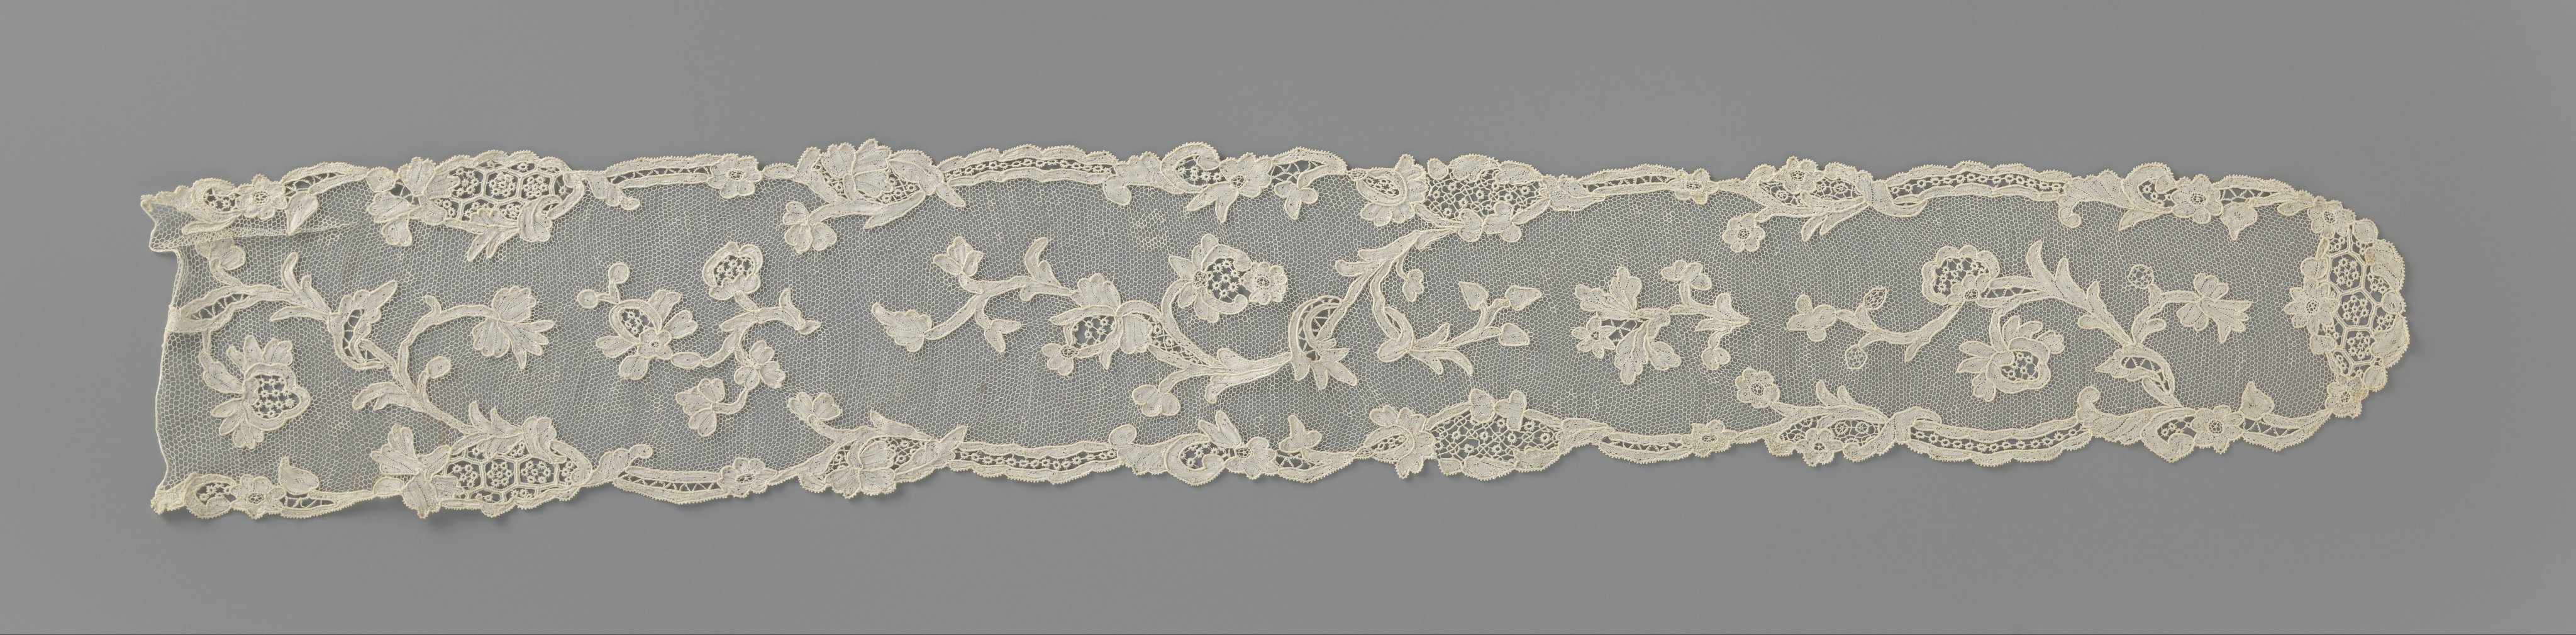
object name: lappet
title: Mutsenslip van naaldkant met hangende bloemen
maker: Anonymous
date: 1760-1790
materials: linen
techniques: lace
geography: france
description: Mutsenslip van naturelkleurige naaldkant: Alençon-kant. Langgerekte schulpen van een golvend lintje, afgewisseld door medaillons met rasterwerk, vormen de buitenranden van een grond, waarop beurtelings een golvende tak met hangende bloemen en granaatappels en een kort bloemtakje staan. In de strook is het patroon symmetrisch ten opzichte van een staande middentak.